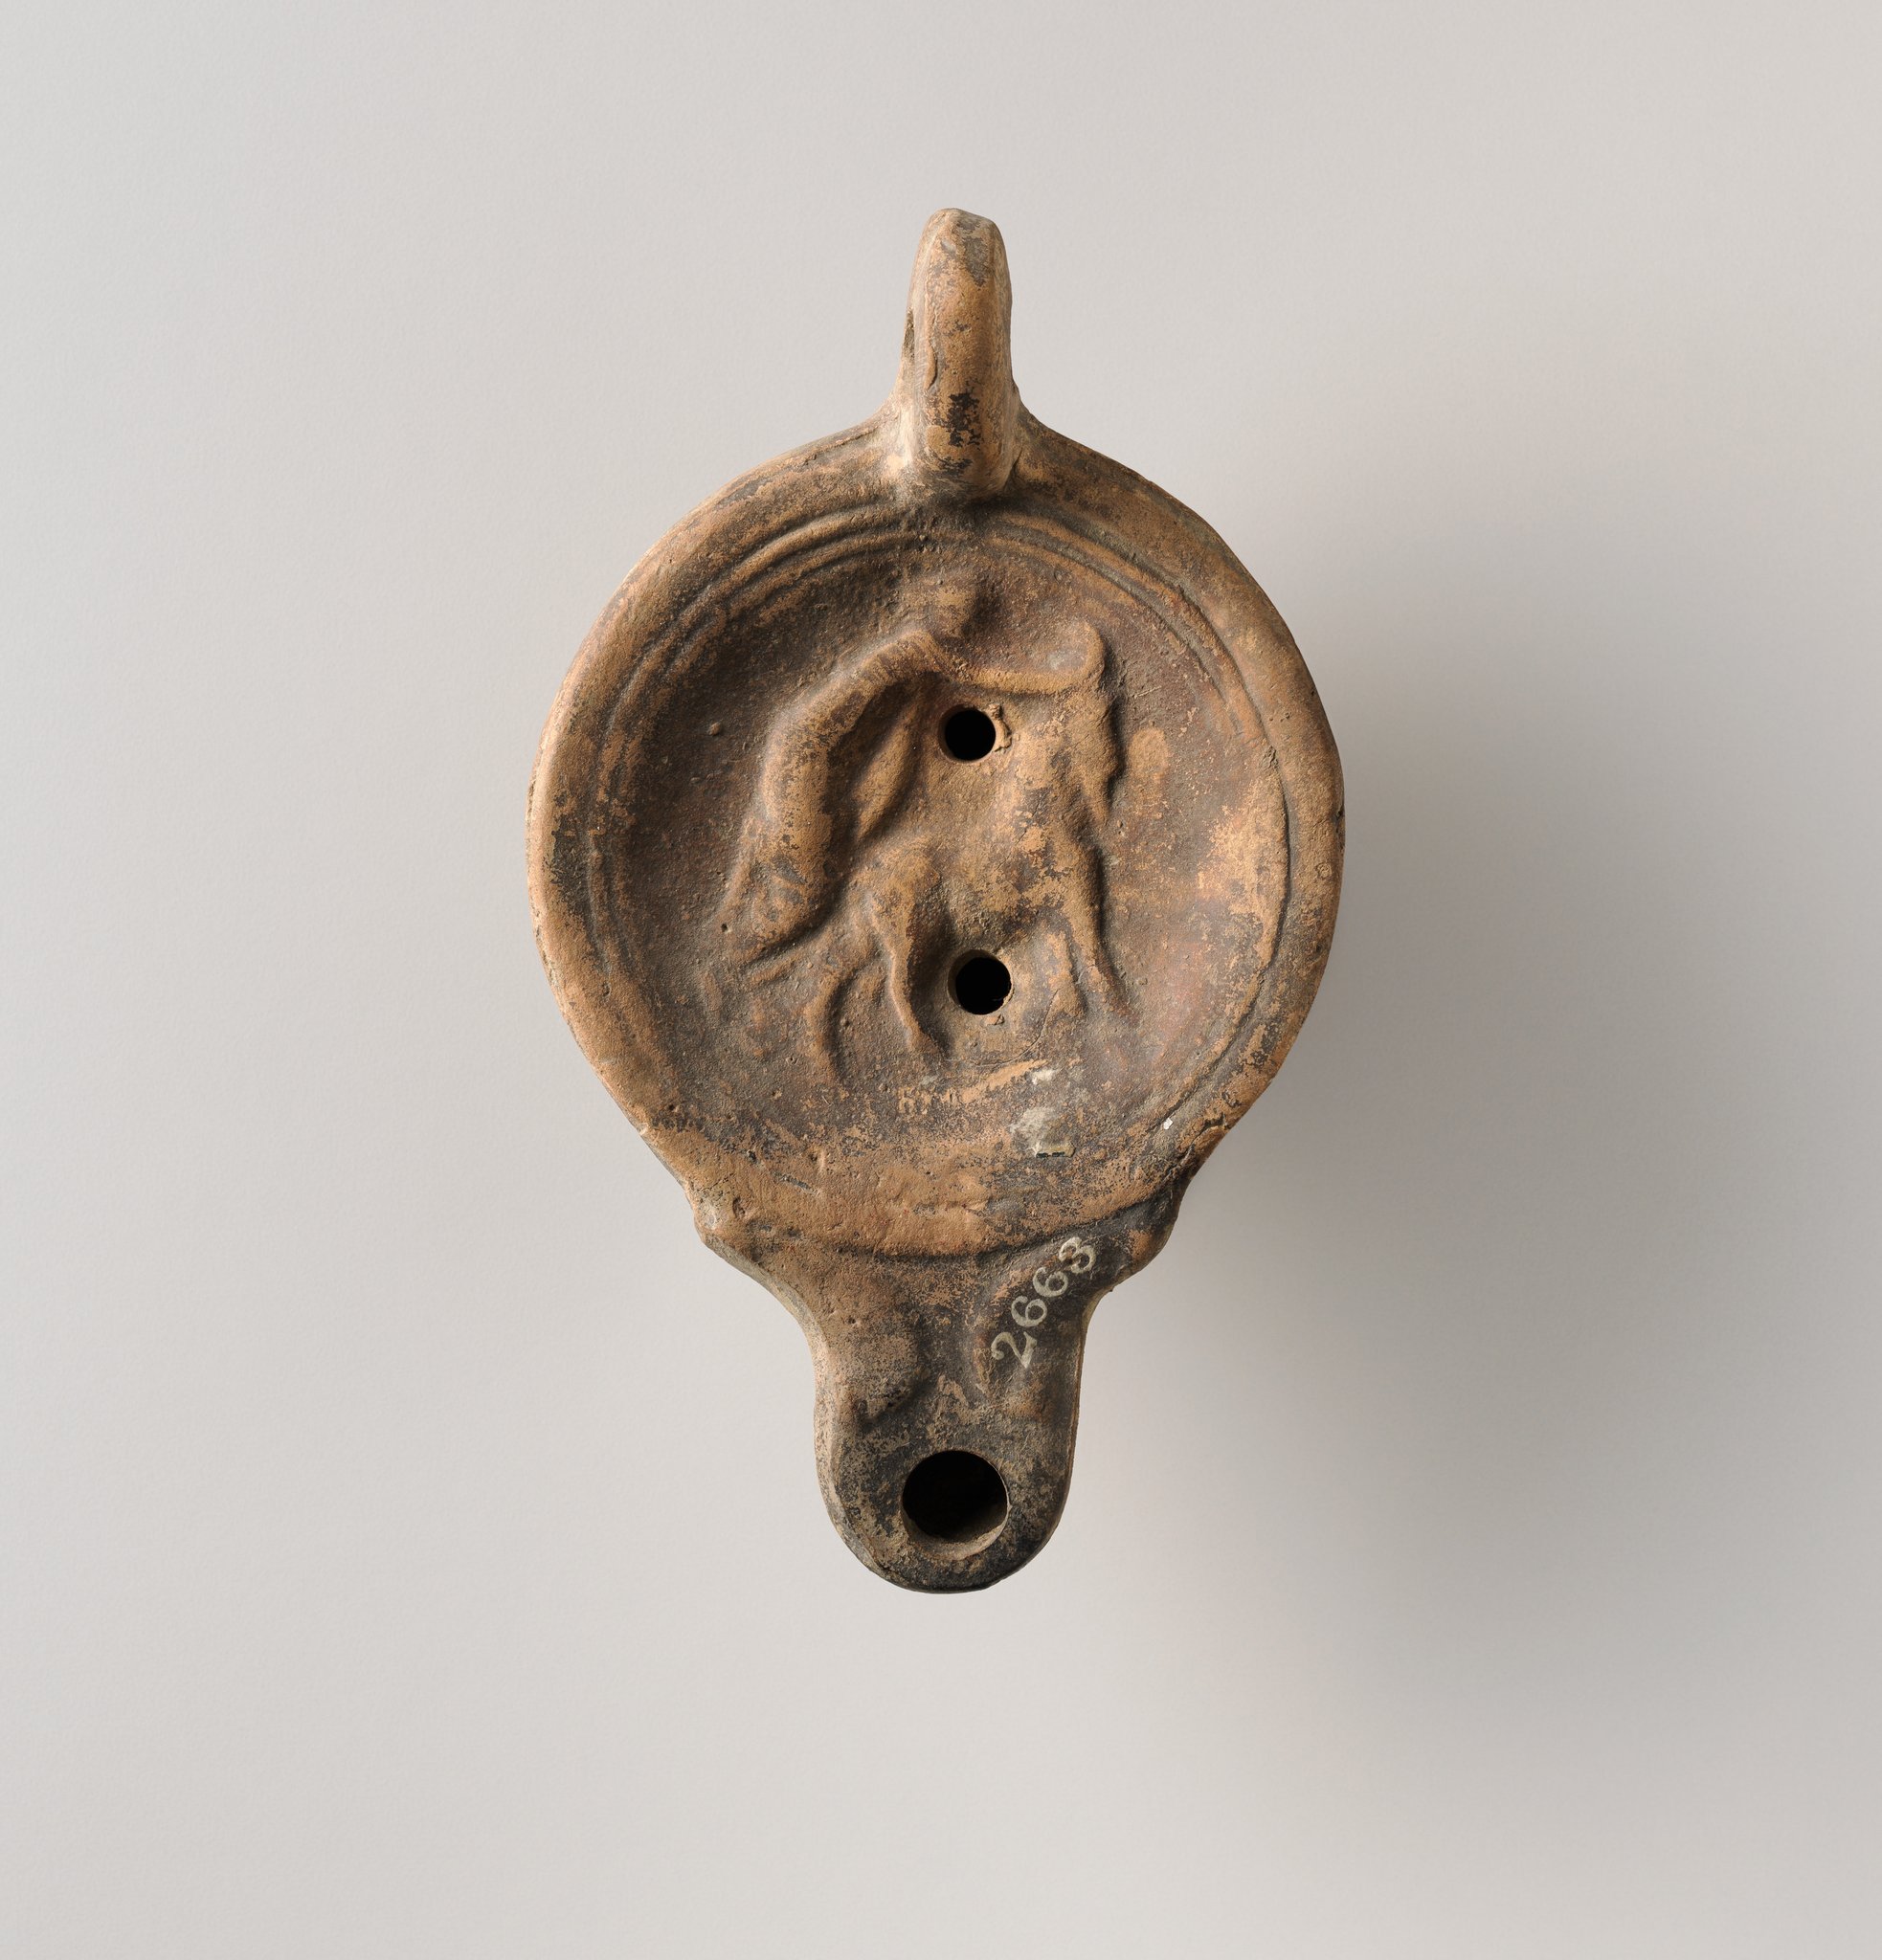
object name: lamp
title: Terracotta oil lamp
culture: roman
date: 100 BCE-100 CE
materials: terracotta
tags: nymphs